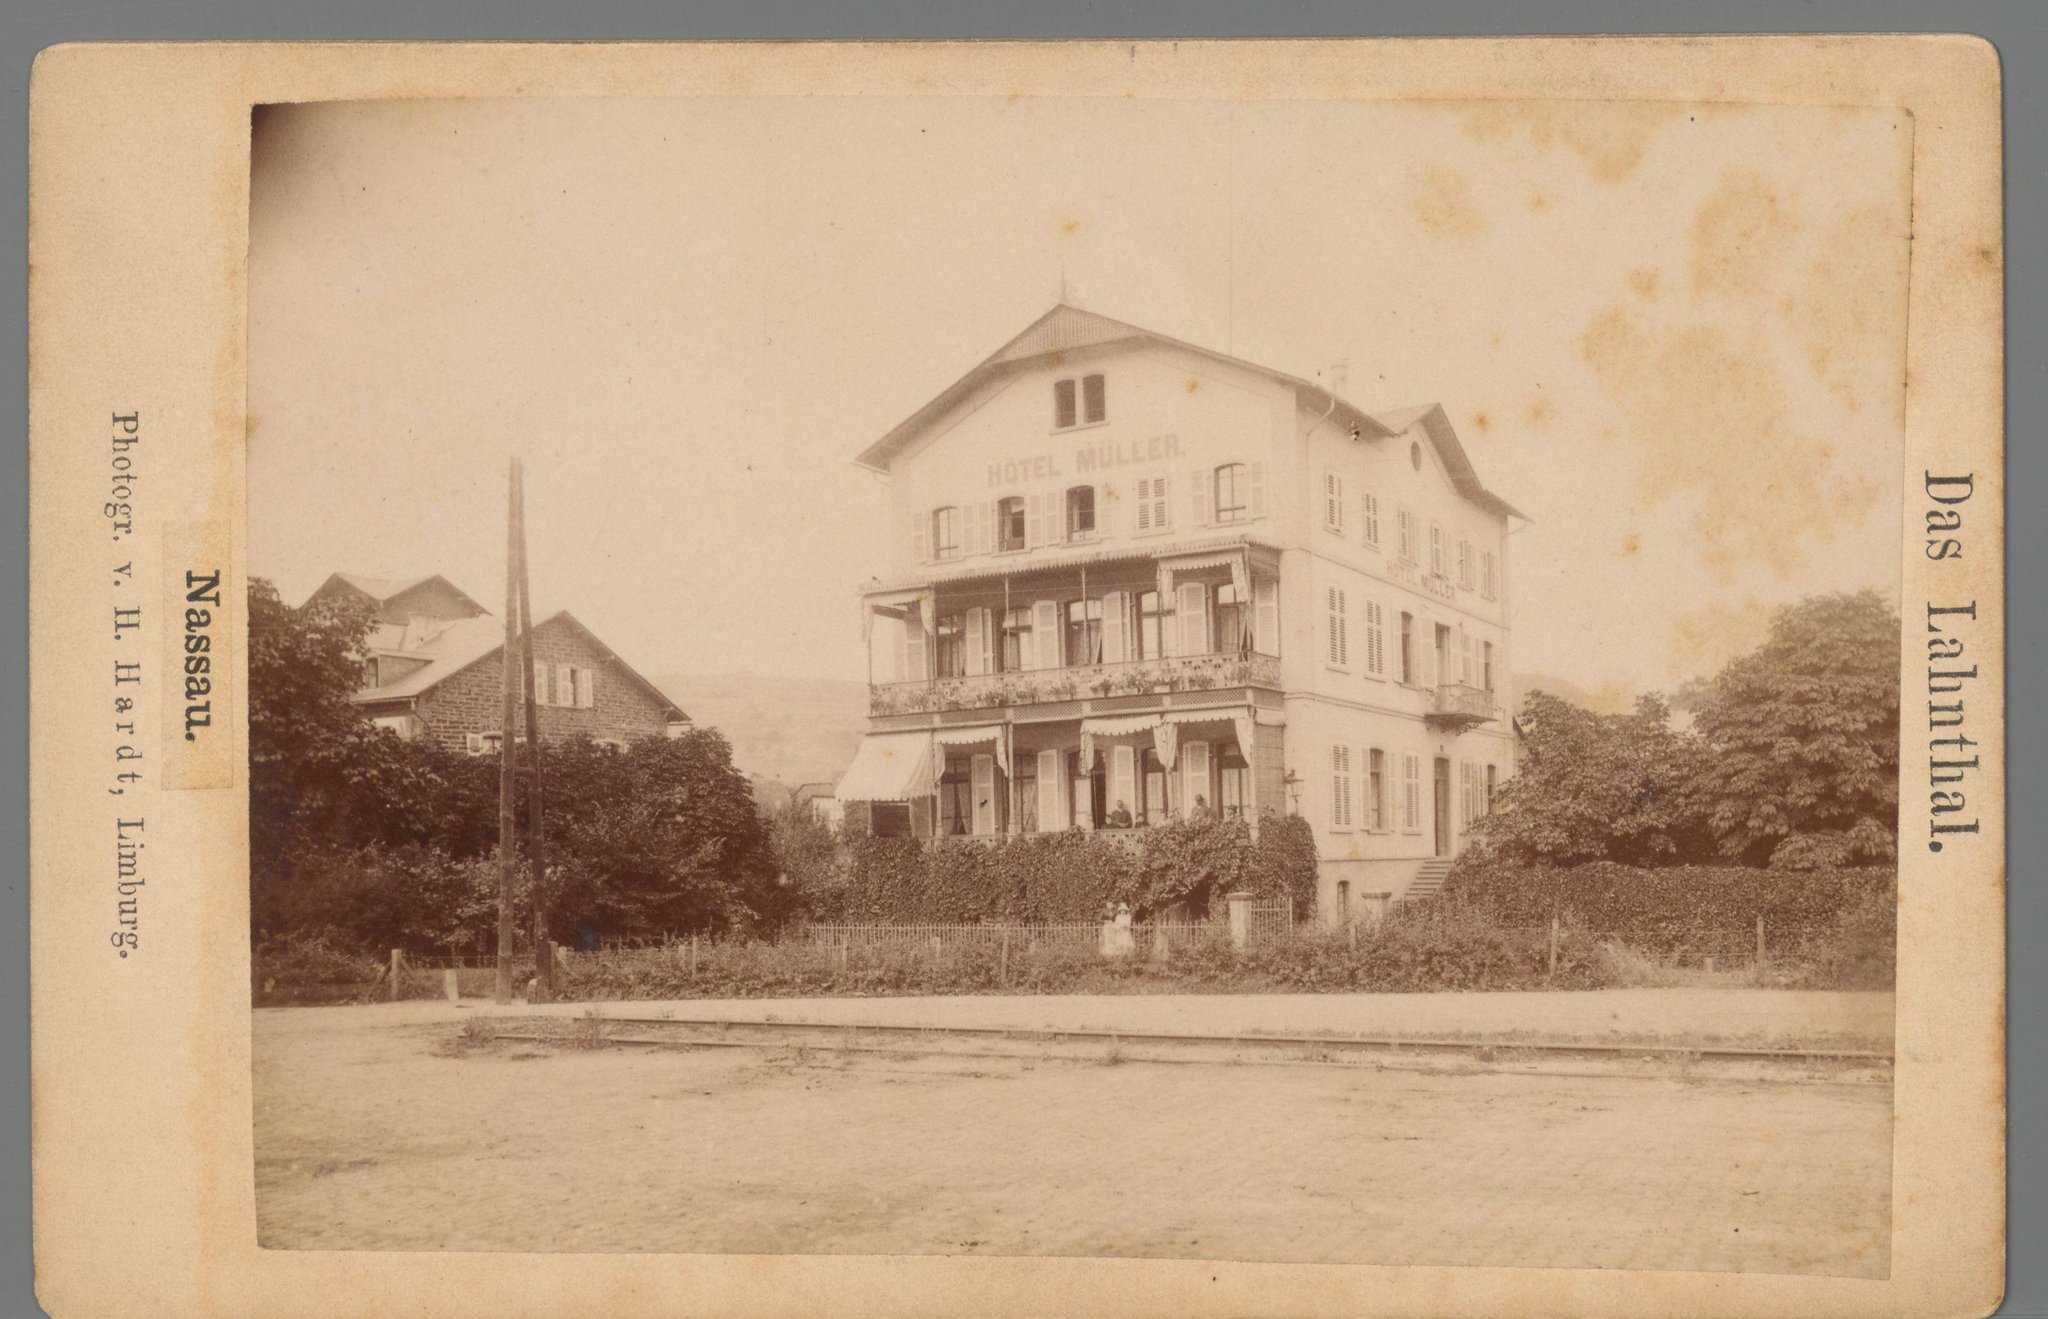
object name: cabinet photograph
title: Das Lahnthal. Nassau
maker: heinrich hardt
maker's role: fotograaf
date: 1866-1920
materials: cardboard, paper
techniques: albumen print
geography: limburg an der lahn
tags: hotel, hostelry, inn